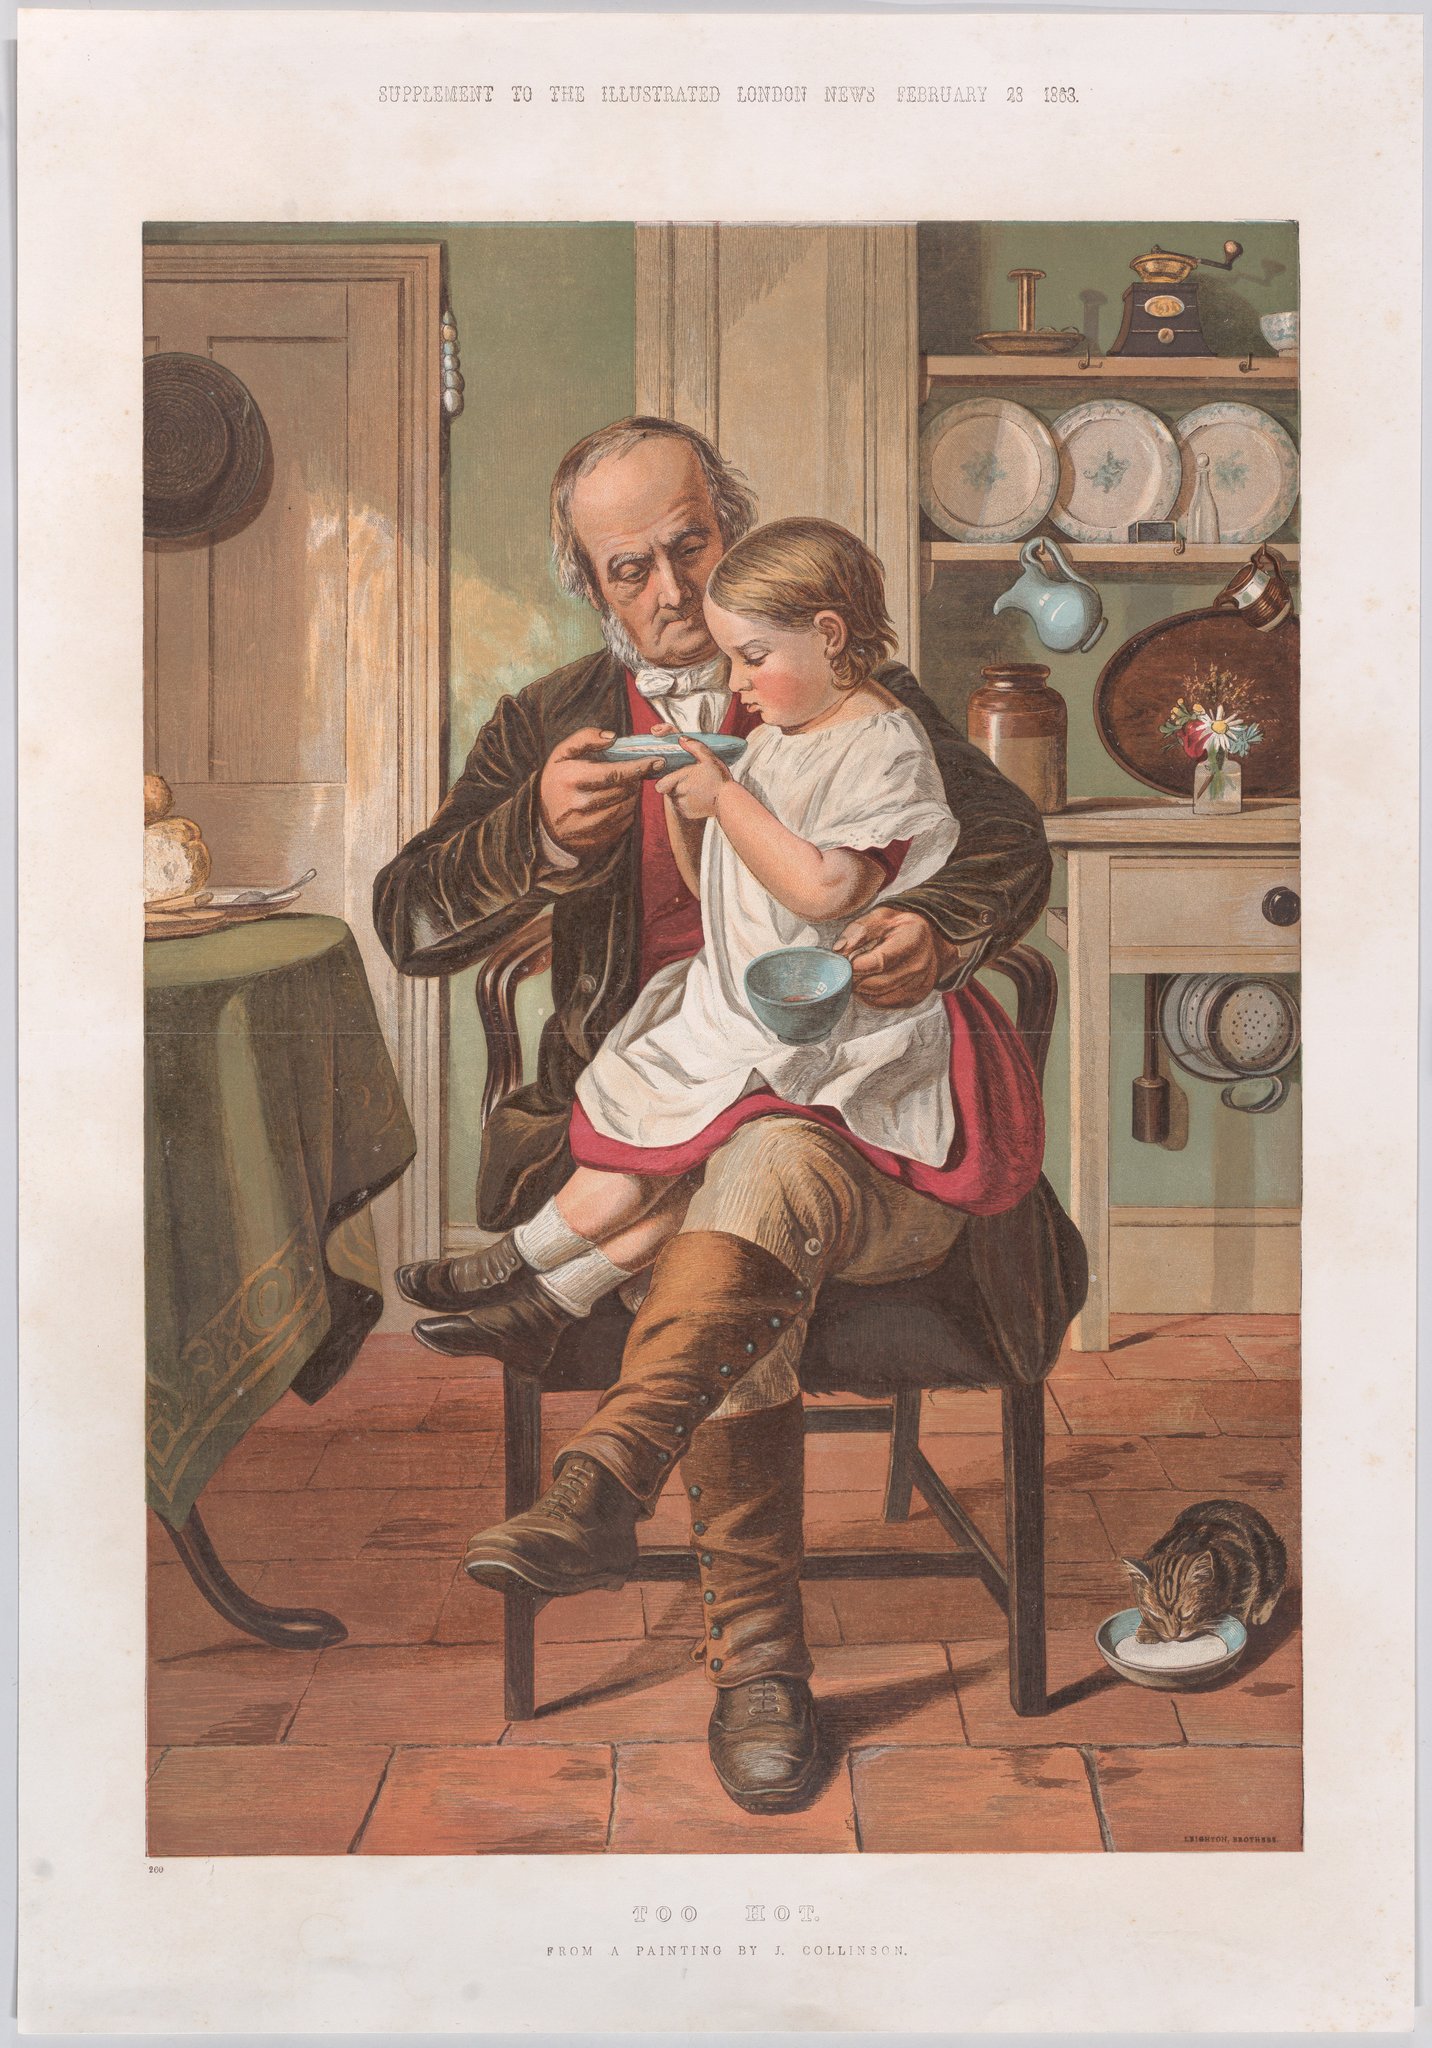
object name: print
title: Too Hot, from "Illustrated London News"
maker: james collinson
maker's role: artist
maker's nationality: british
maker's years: 1825-1881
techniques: engraving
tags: girls,men,cats,drinking